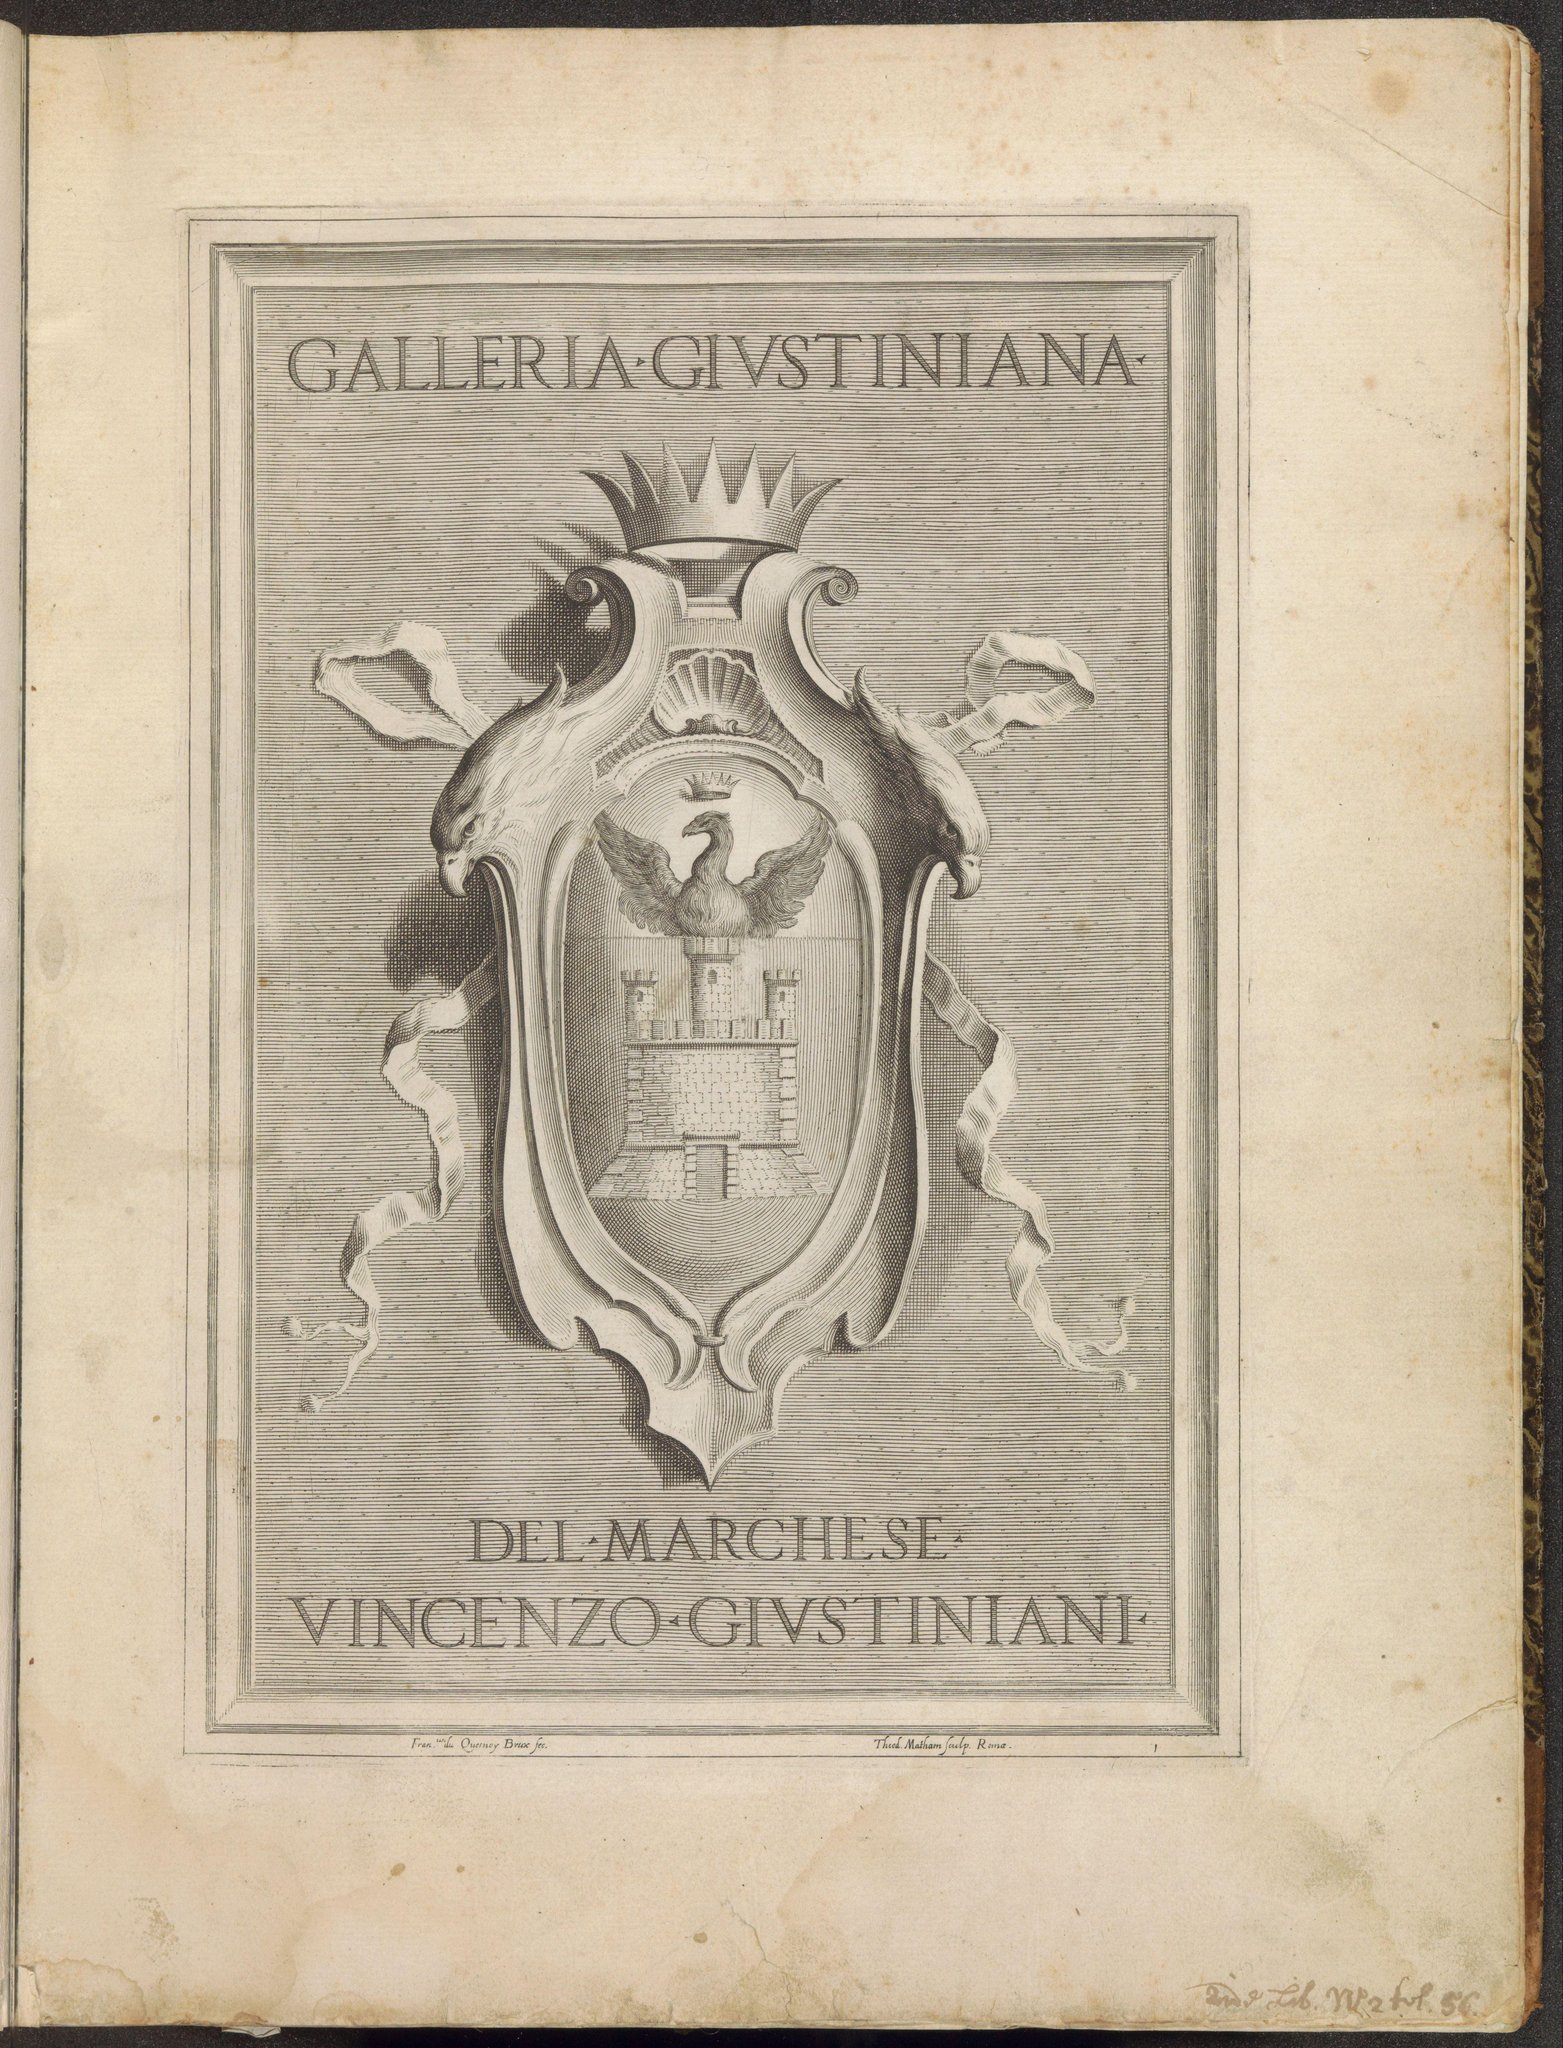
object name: print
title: Wapenschild van Vincenzo Giustiniani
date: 1636-1647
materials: paper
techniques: engraving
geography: rome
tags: piece of sculpture, reproduction of a piece of sculpture, armorial bearing, heraldry